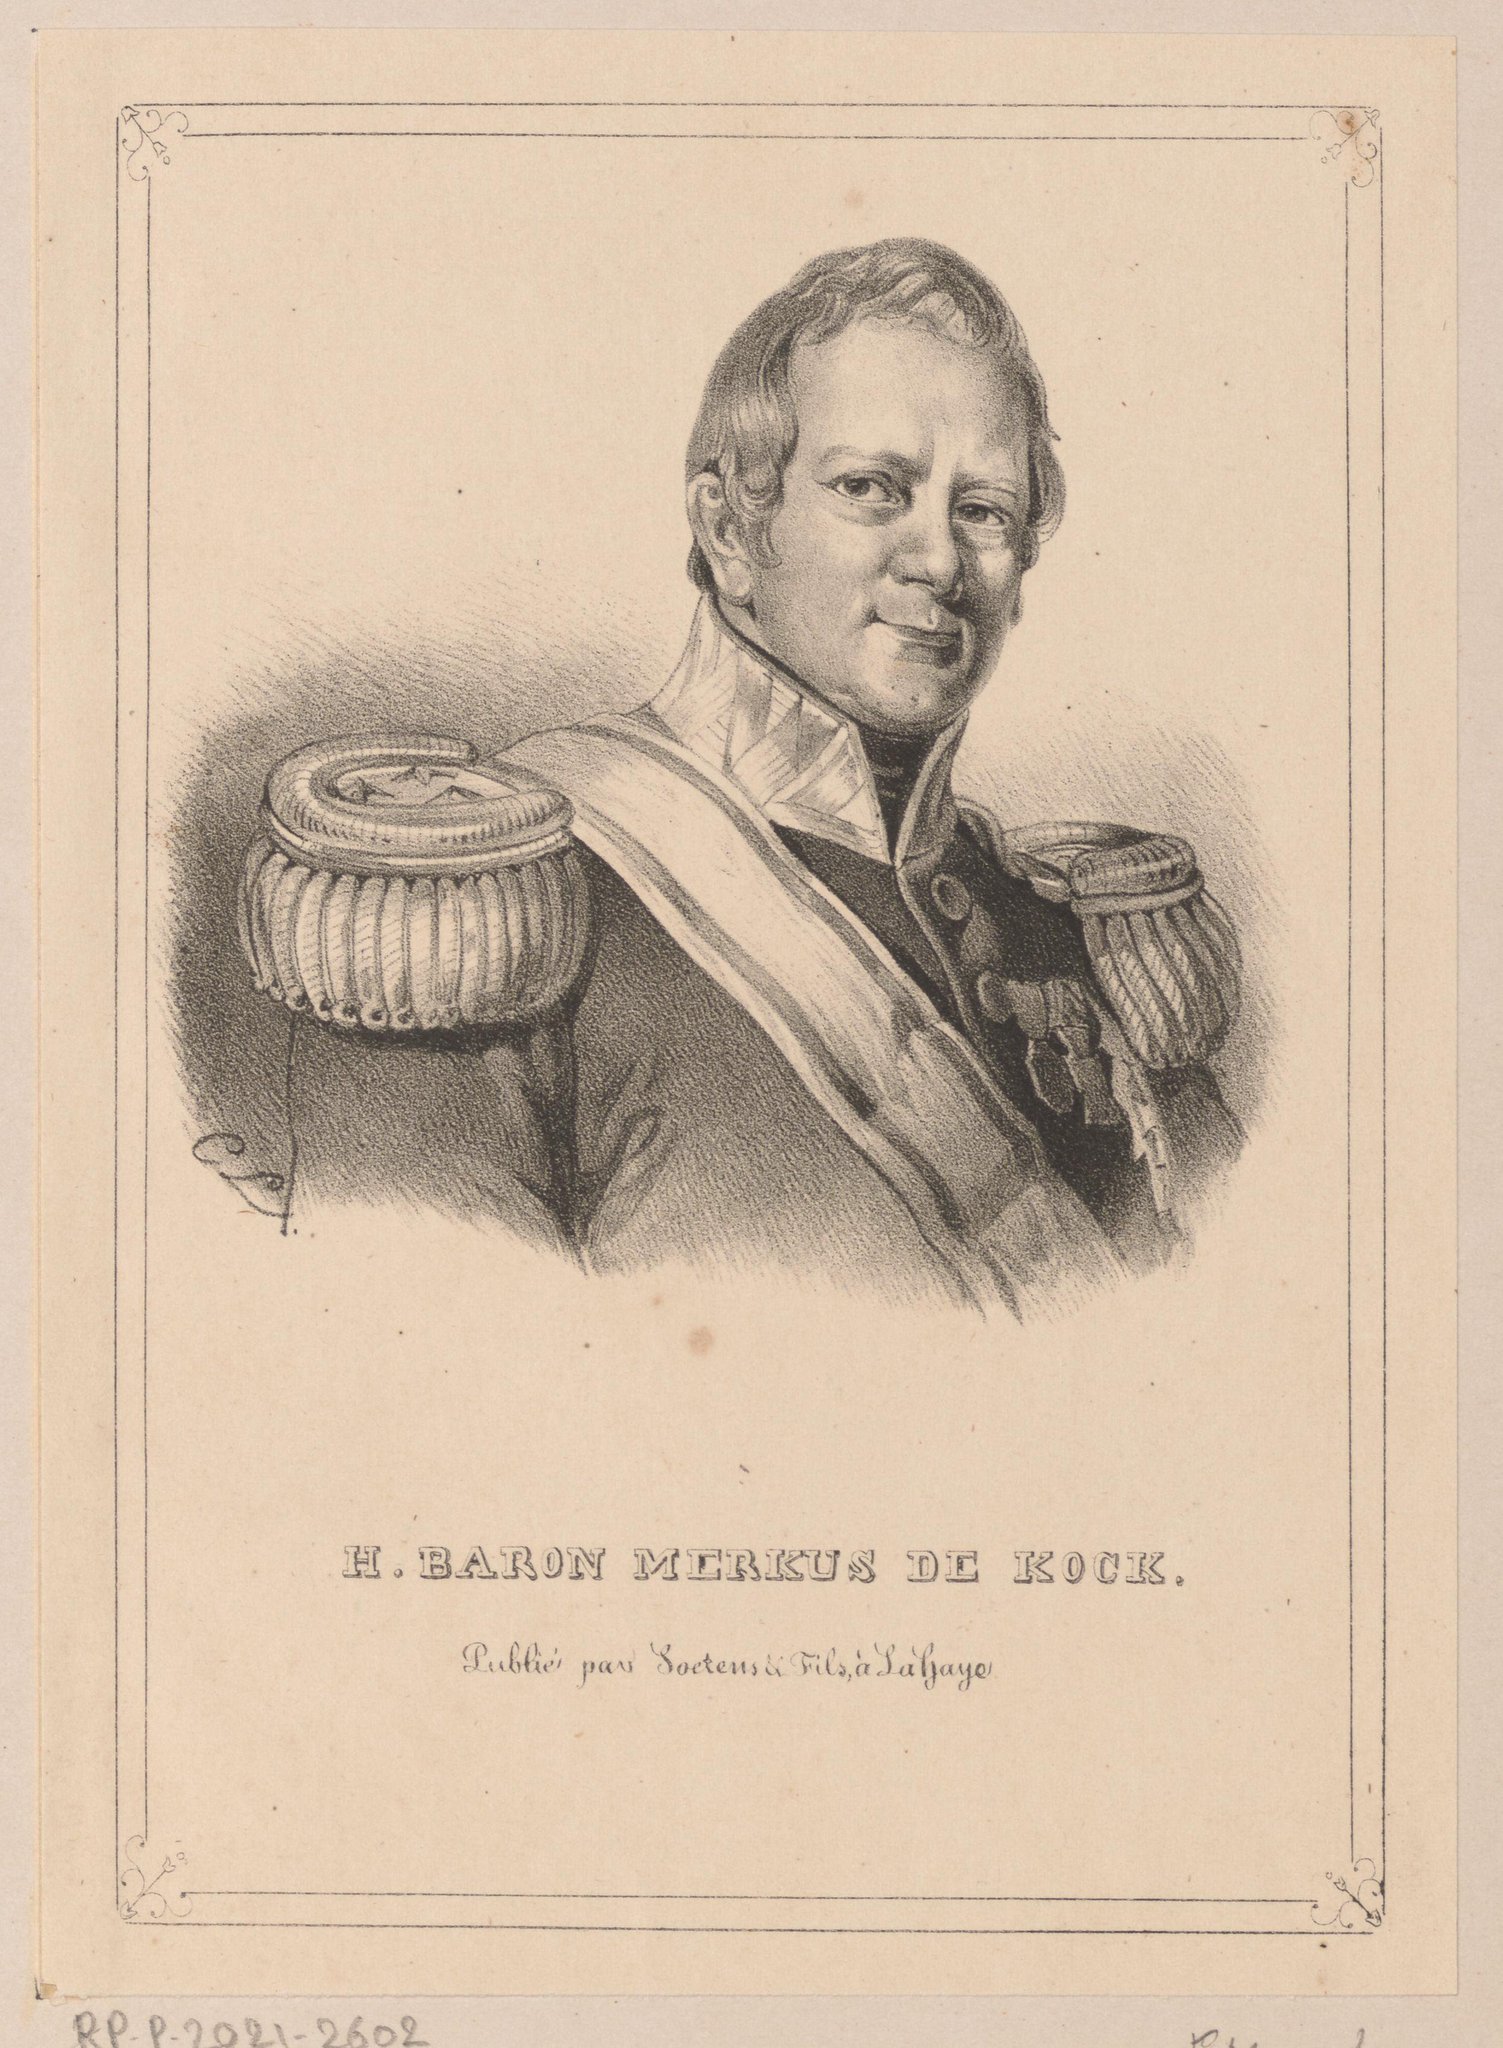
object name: print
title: Portret van Hendrik Merkus baron de Kock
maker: carel christiaan antony last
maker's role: print maker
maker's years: 1808-1876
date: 1837-1840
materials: paper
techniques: lithograph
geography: the hague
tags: the hague, historical persons